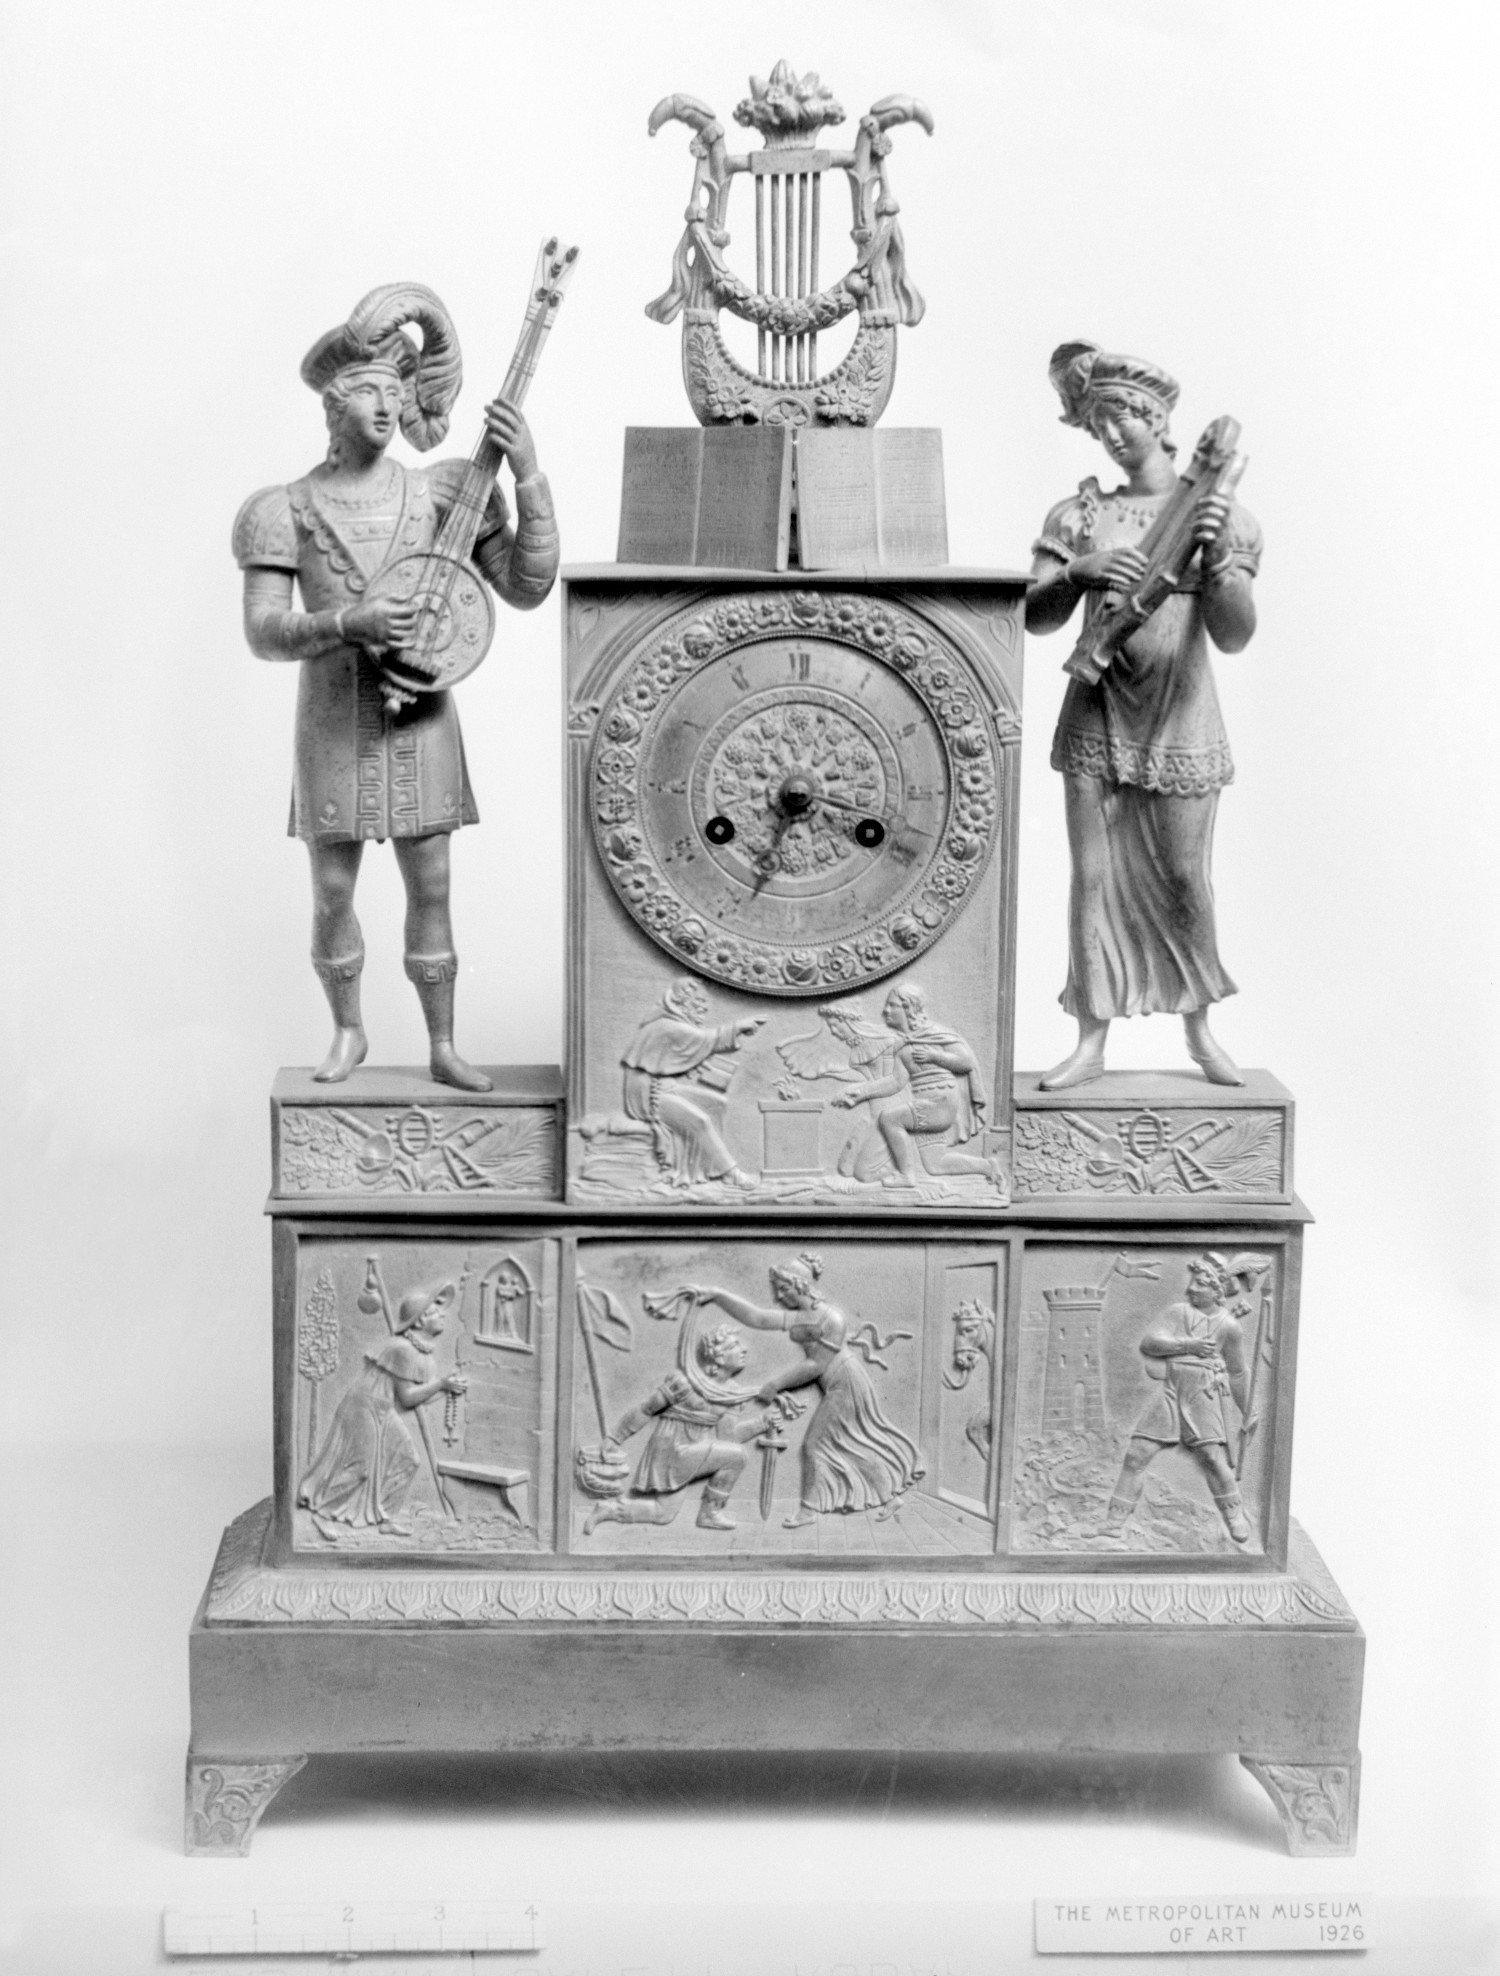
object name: clock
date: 1825-1830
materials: gilt bronze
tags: musical instruments,men,women,lyres